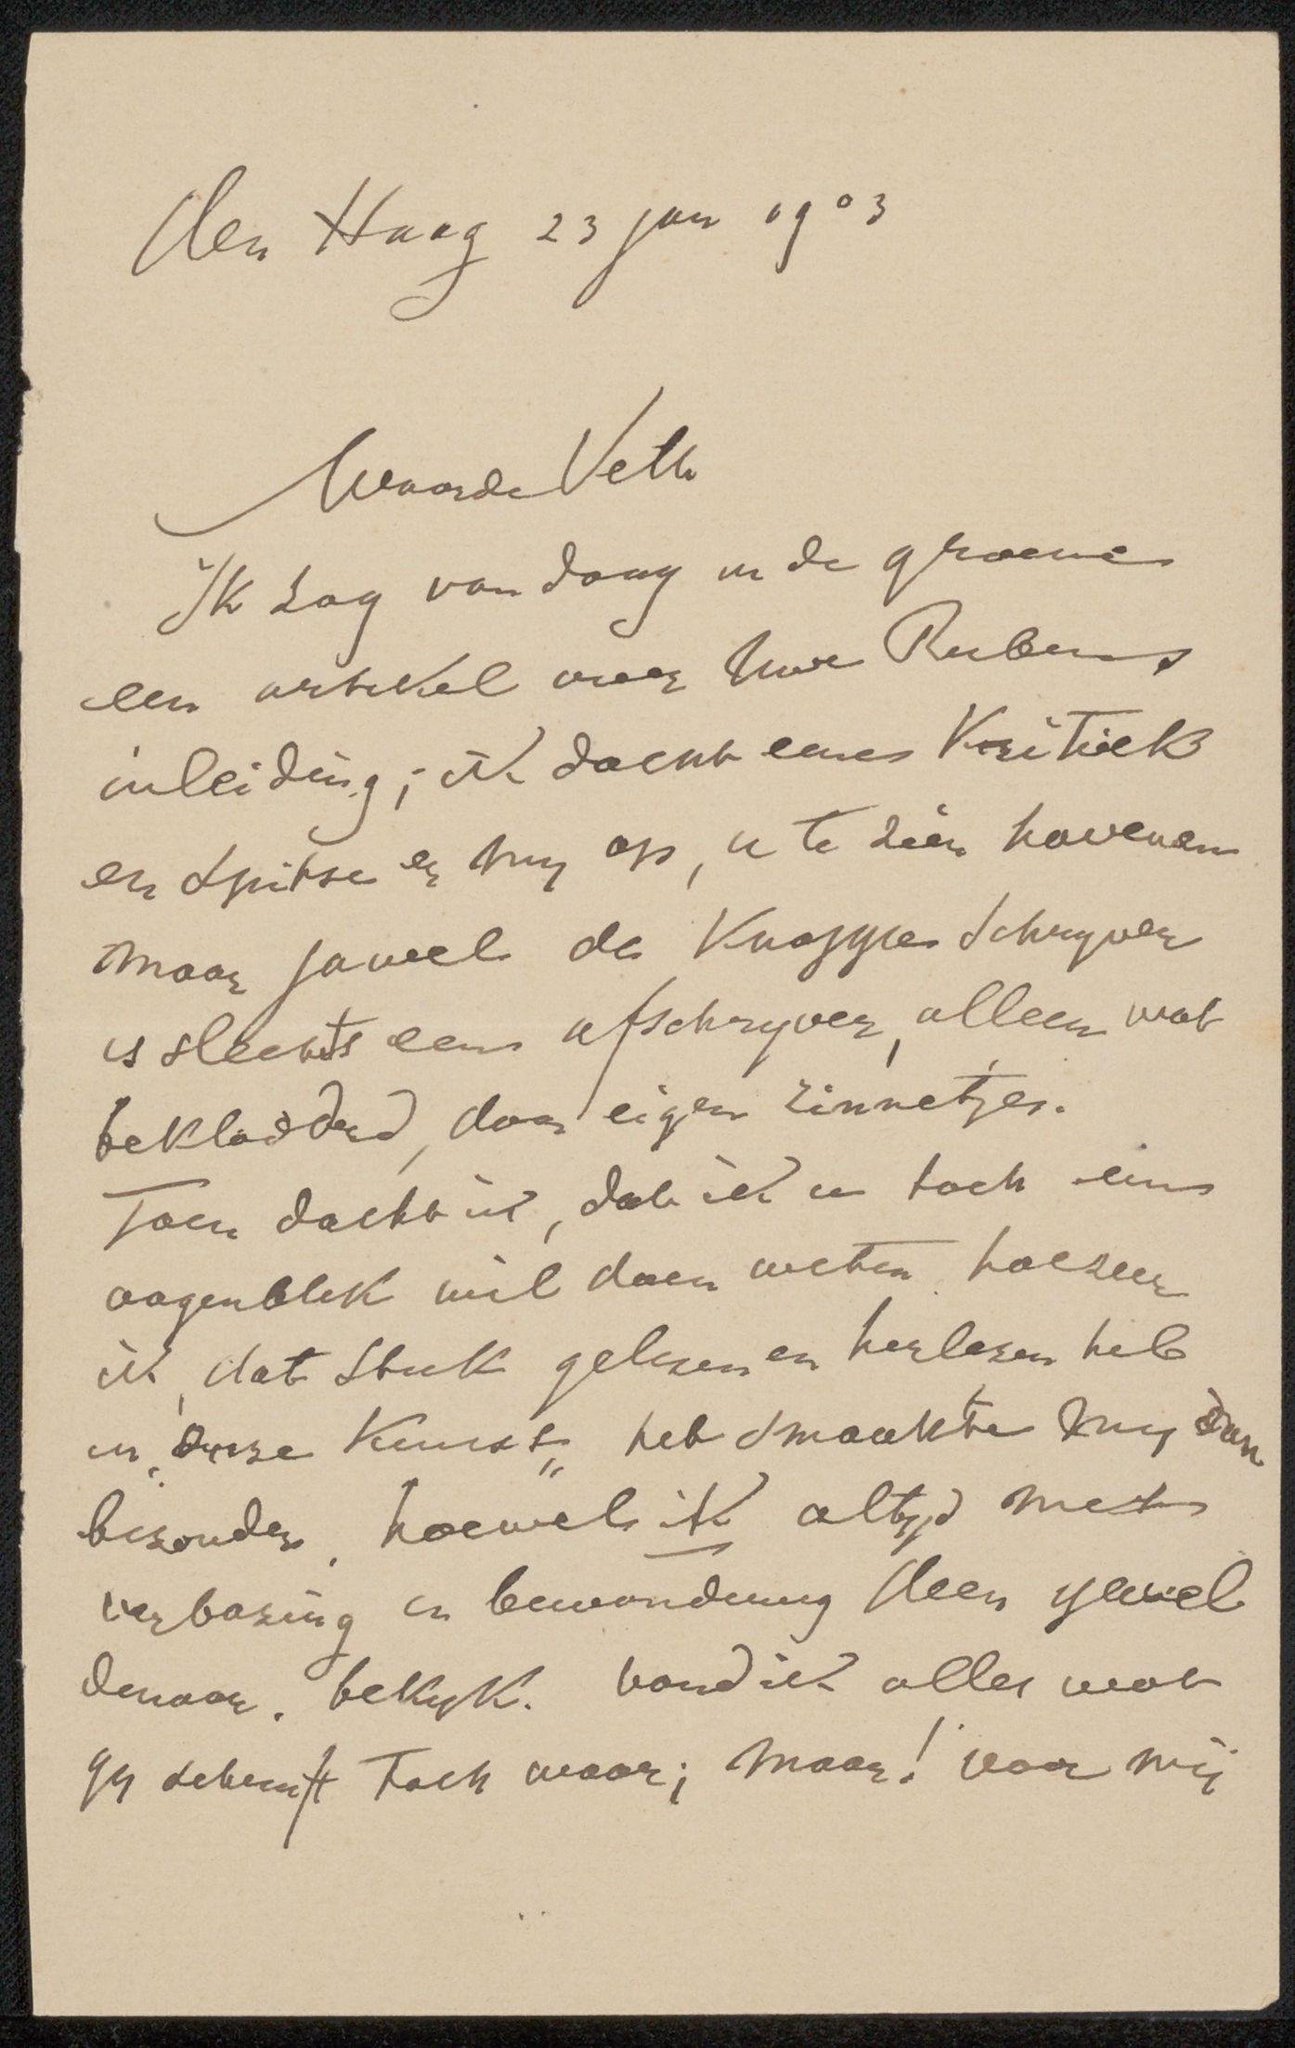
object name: letter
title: Brief aan Jan Veth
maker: jozef israëls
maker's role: draughtsman, painter, print maker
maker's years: 1824-1911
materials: ink, paper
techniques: pen, writing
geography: the hague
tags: jan veth, amsterdam, rembrandt van rijn, antwerp, painter, print maker, draughtsman, peter paul rubens, painting (including book-illumination, miniature-painting), bruges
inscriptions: collector's mark: ‘RPK’, watermark